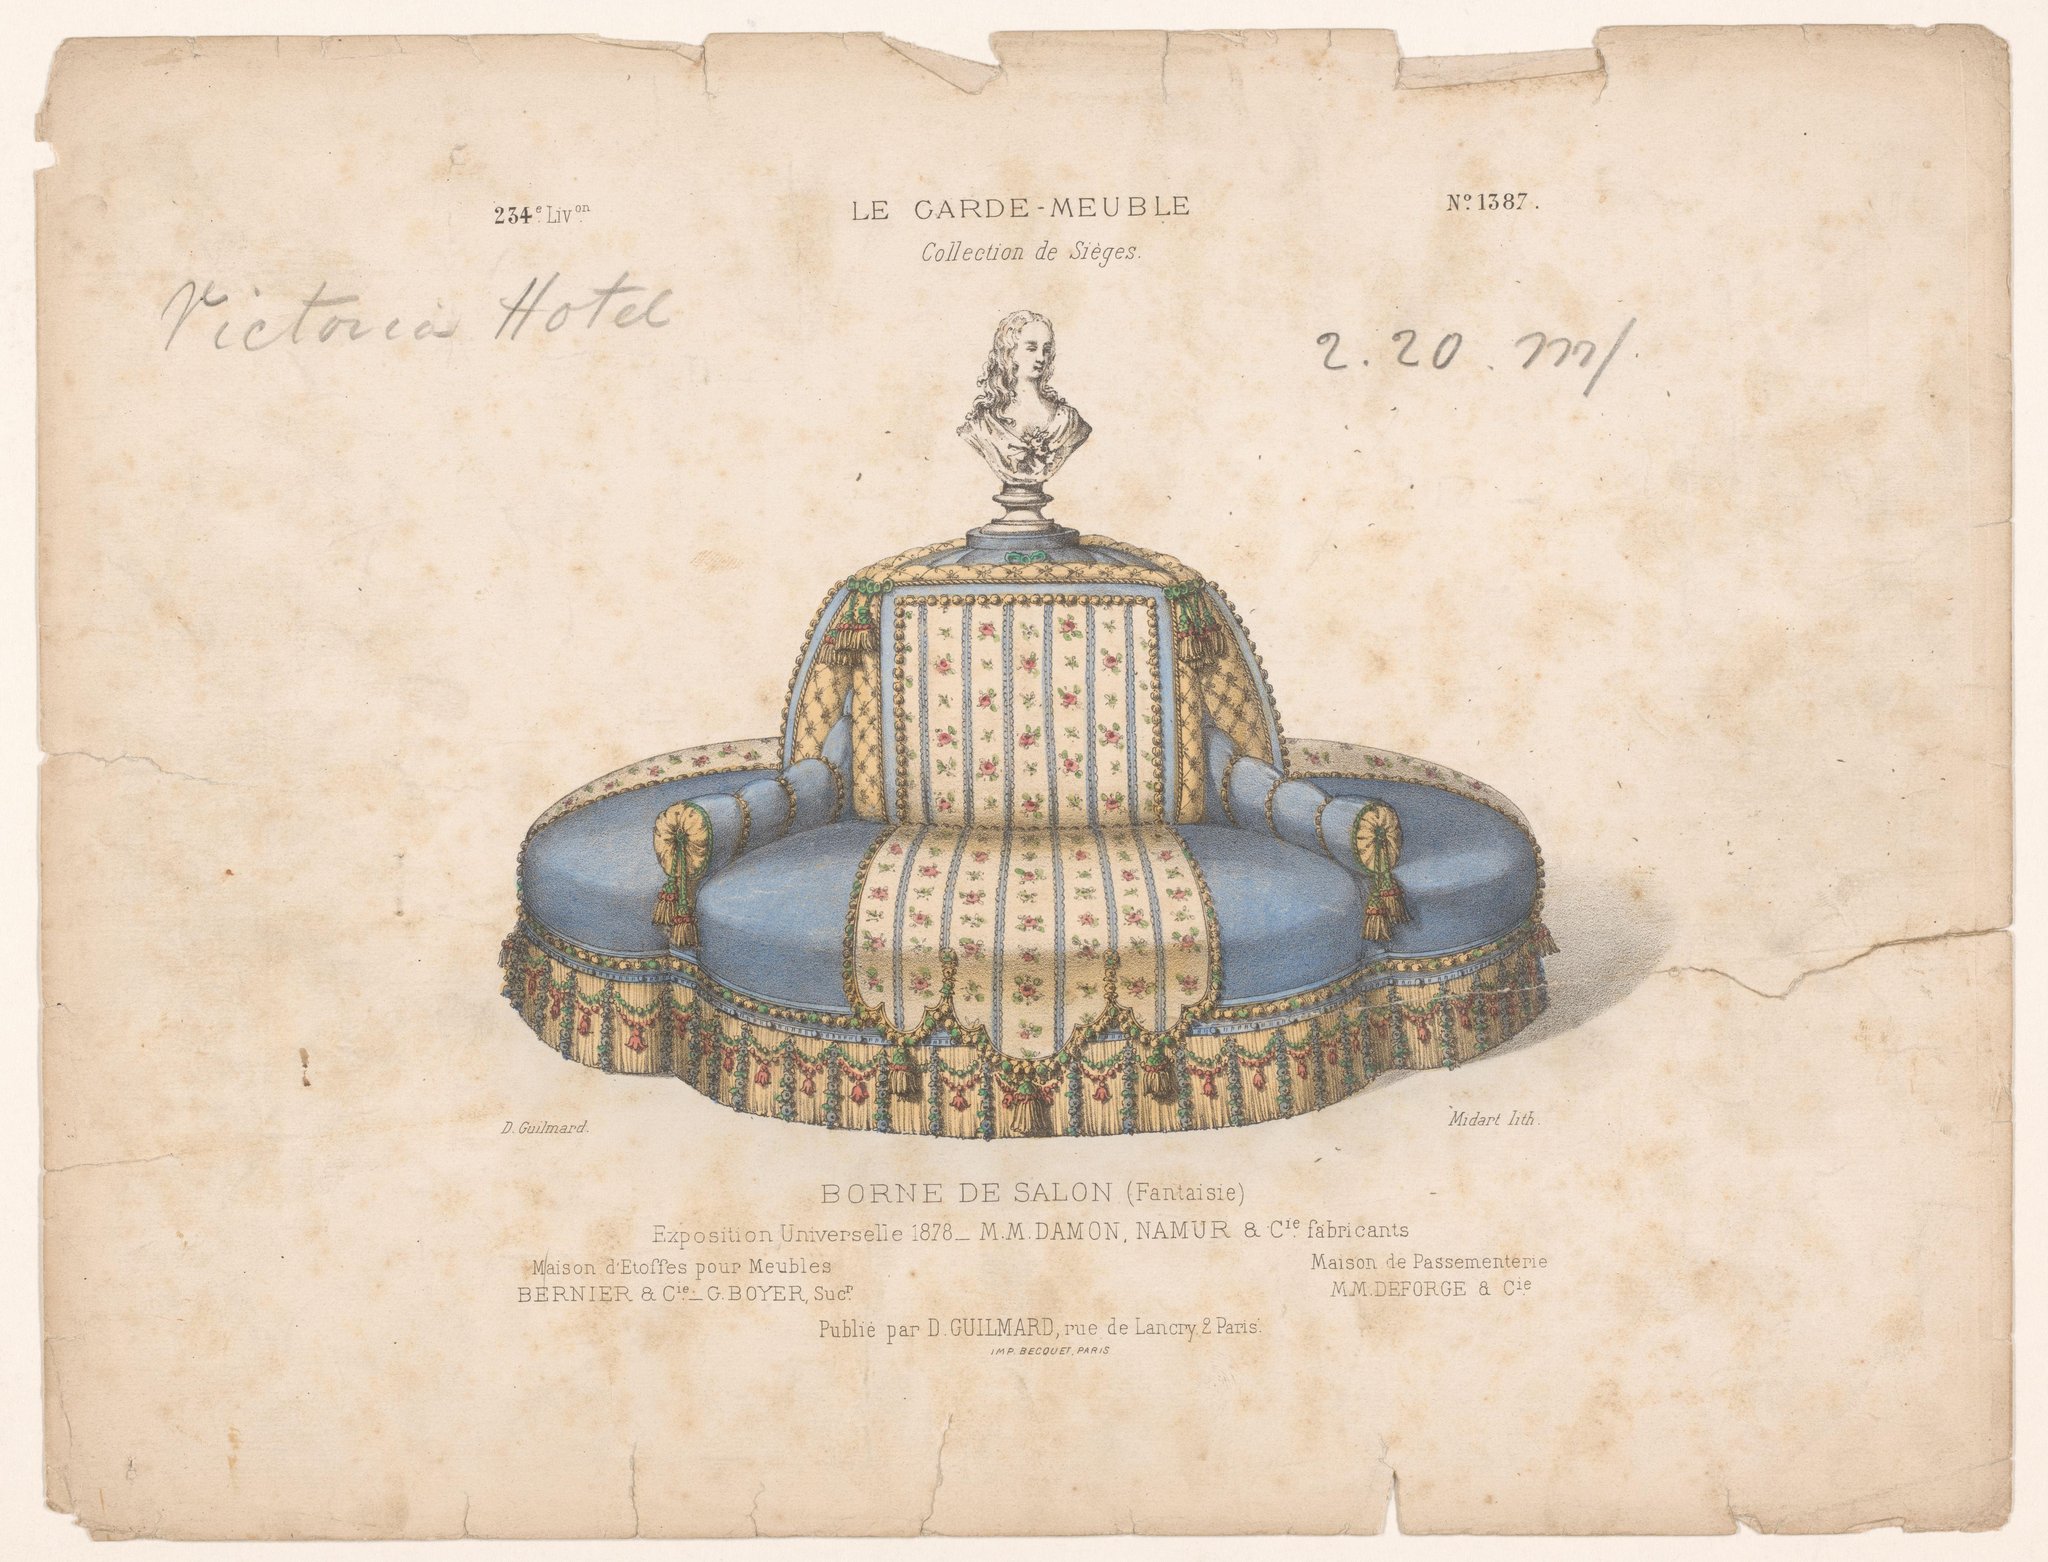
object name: print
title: Borne de salon (Fantaisie)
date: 1839-1885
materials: paper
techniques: hand coloring, lithograph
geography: paris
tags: seating furniture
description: Ieder Livraison in de serie Le Garde-Meuble bevat negen platen: drie 'sièges' (zitmeubels), drie 'meubles' (diverse meubels zoals tafels en kasten) en drie 'tentures' (gordijnen en draperieën).